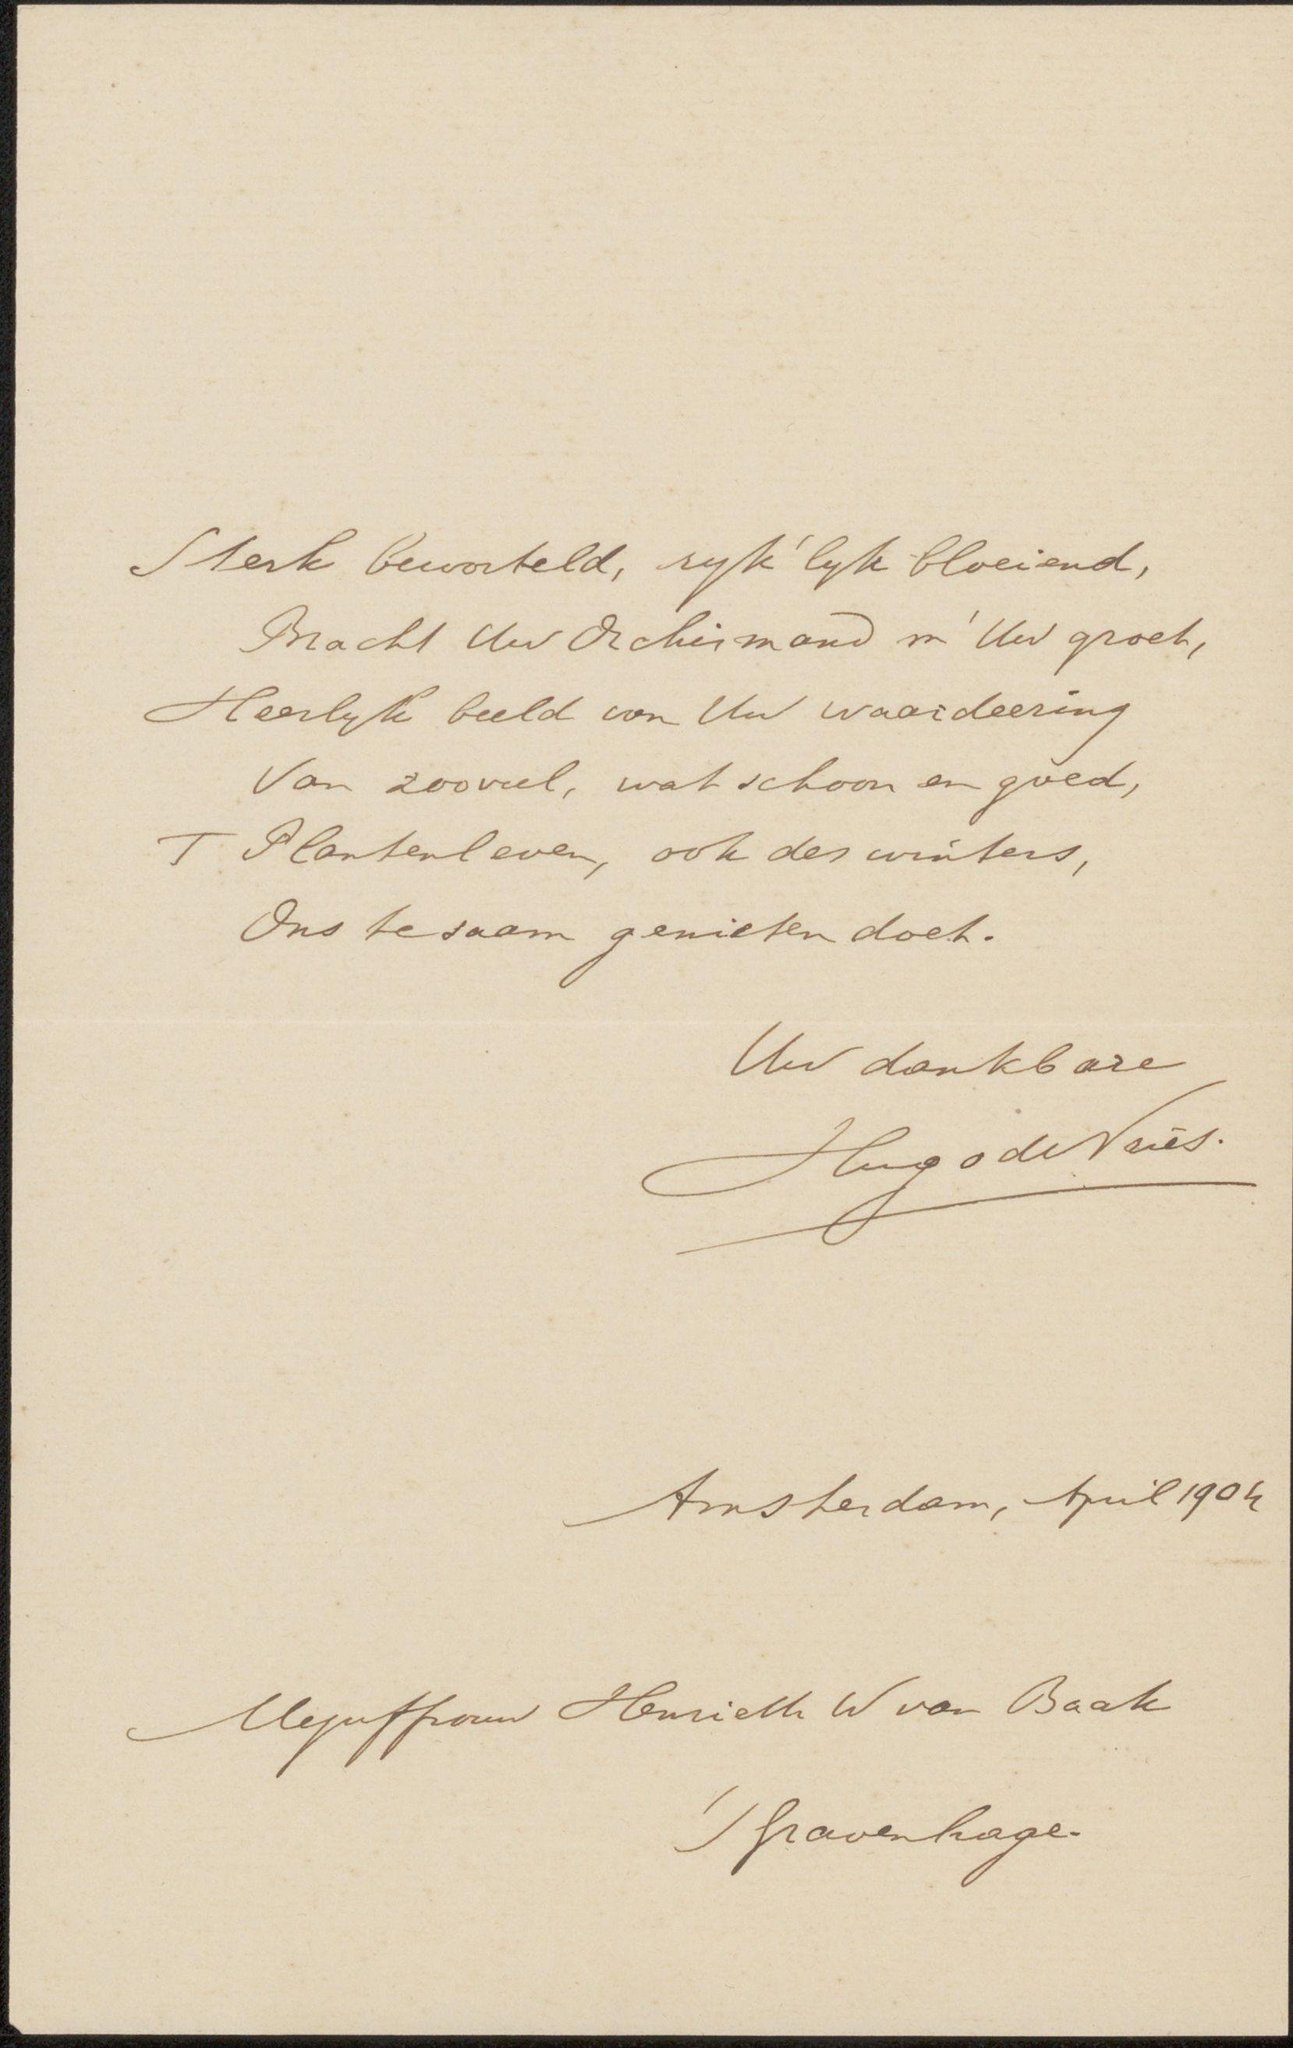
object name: letter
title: Brief aan Henriette Wilhelmina van Baak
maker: hugo de vries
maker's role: bioloog, hoogleraar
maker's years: 1848-1935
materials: ink, paper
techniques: pen, writing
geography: amsterdam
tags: henriette wilhelmina van baak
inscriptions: collector's mark: ‘RPK’